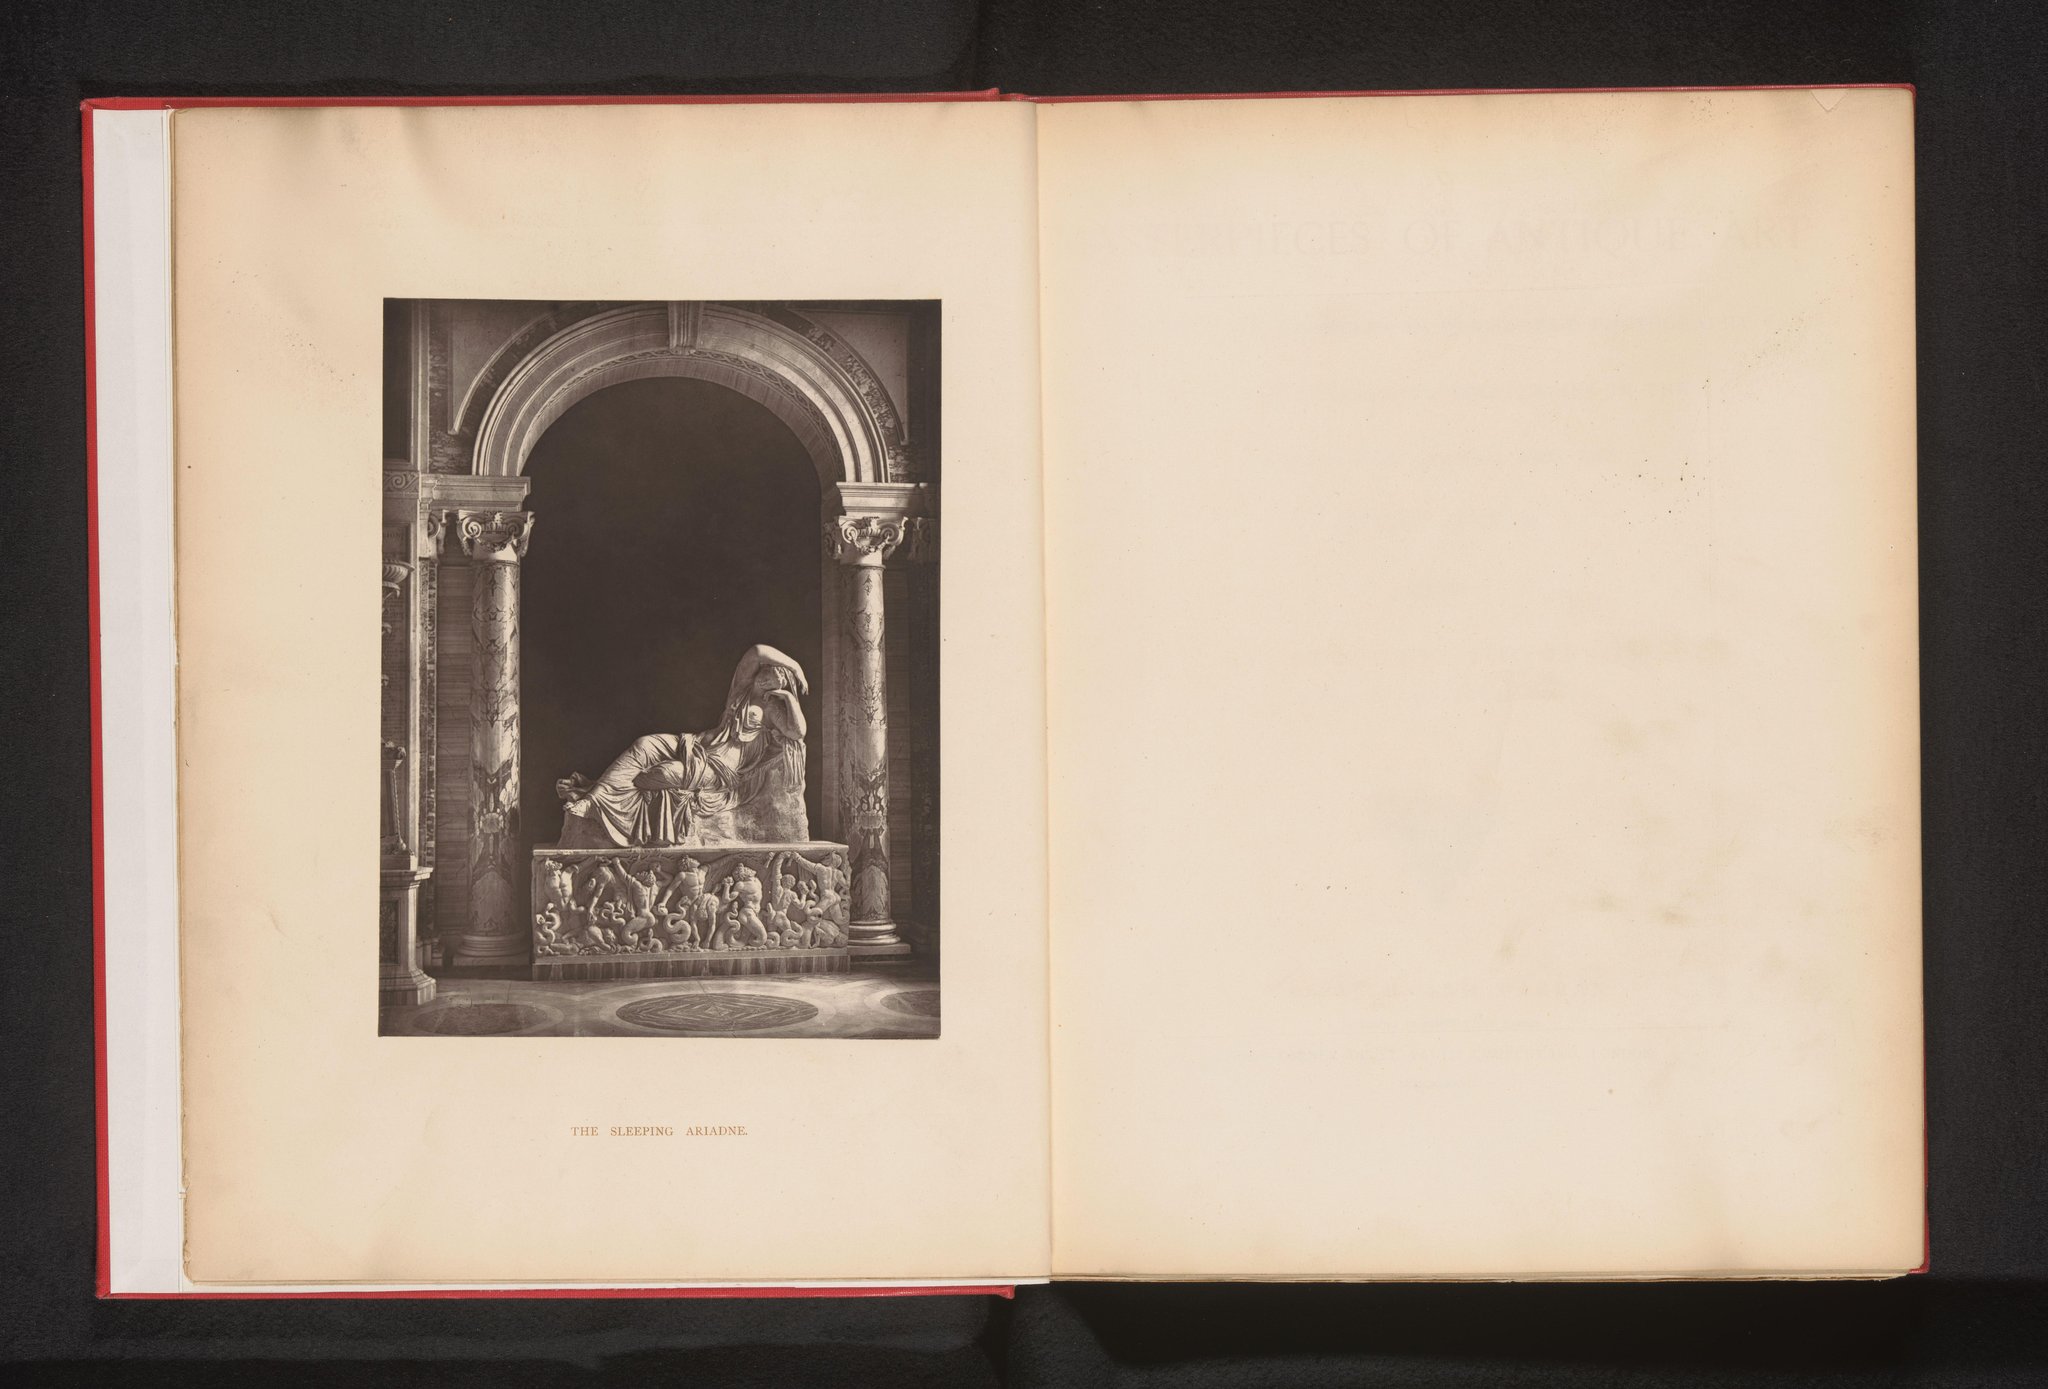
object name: page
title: The sleeping Ariadne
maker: stephen thompson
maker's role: fotograaf, schrijver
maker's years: 1831-1893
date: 1873-1878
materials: paper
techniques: woodburytype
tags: (story of) ariadne, sculpture